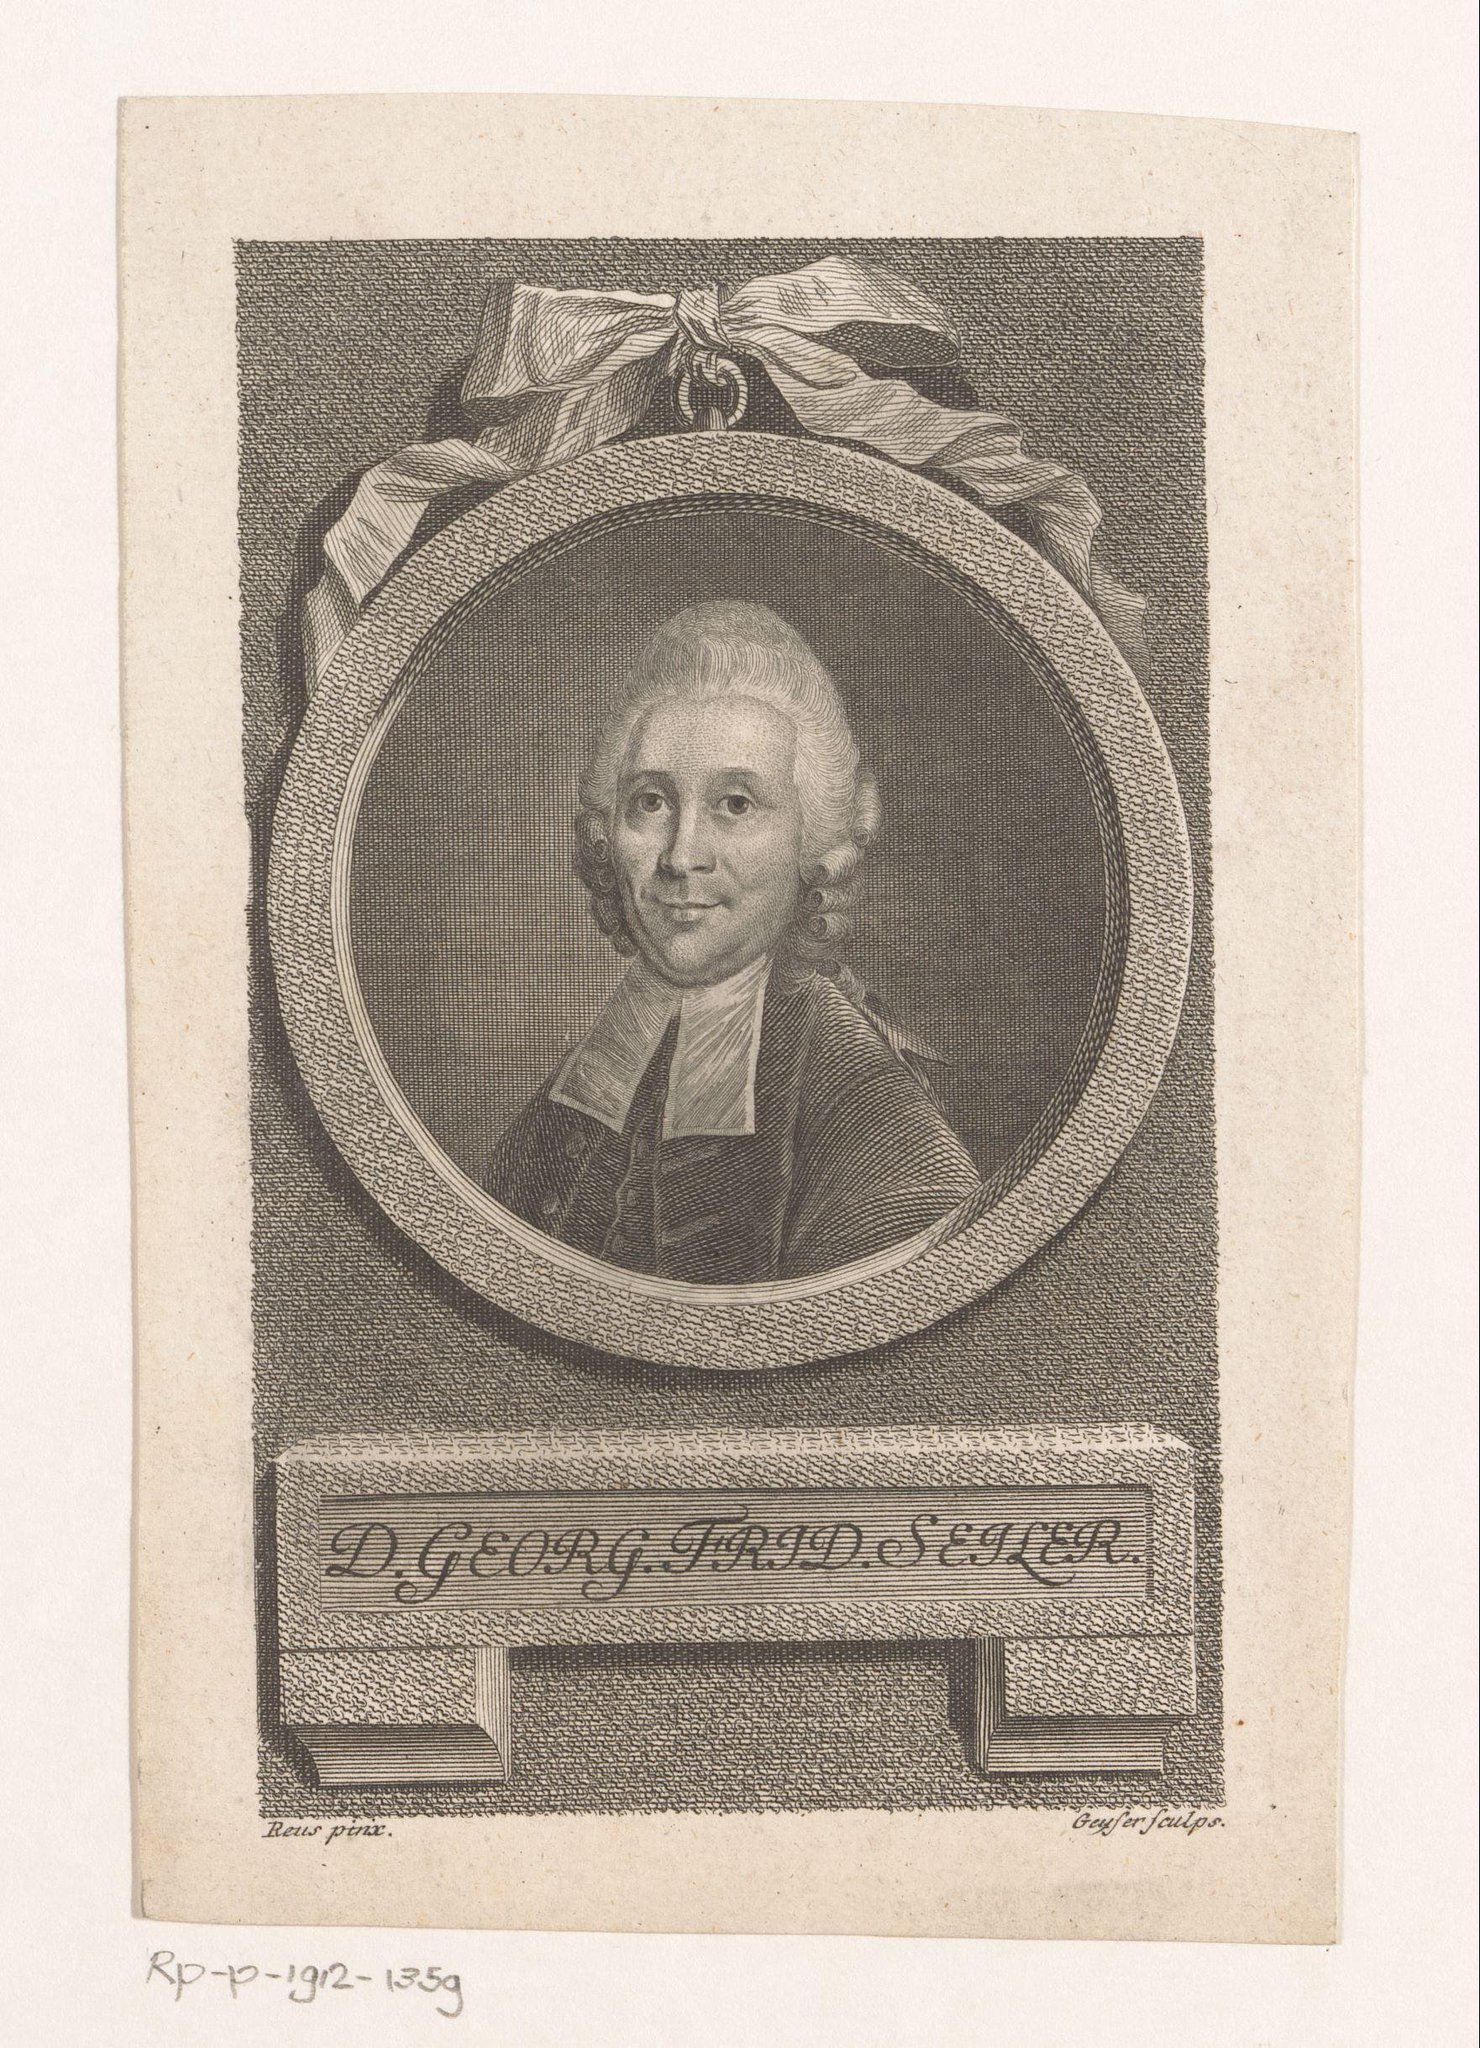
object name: print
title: Portret van Georg Friedrich Seiler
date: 1752-1803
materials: paper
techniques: engraving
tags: theologian, ornament ~ medallion, historical persons, portrait of a writer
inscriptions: collector's mark: Lugt 2228